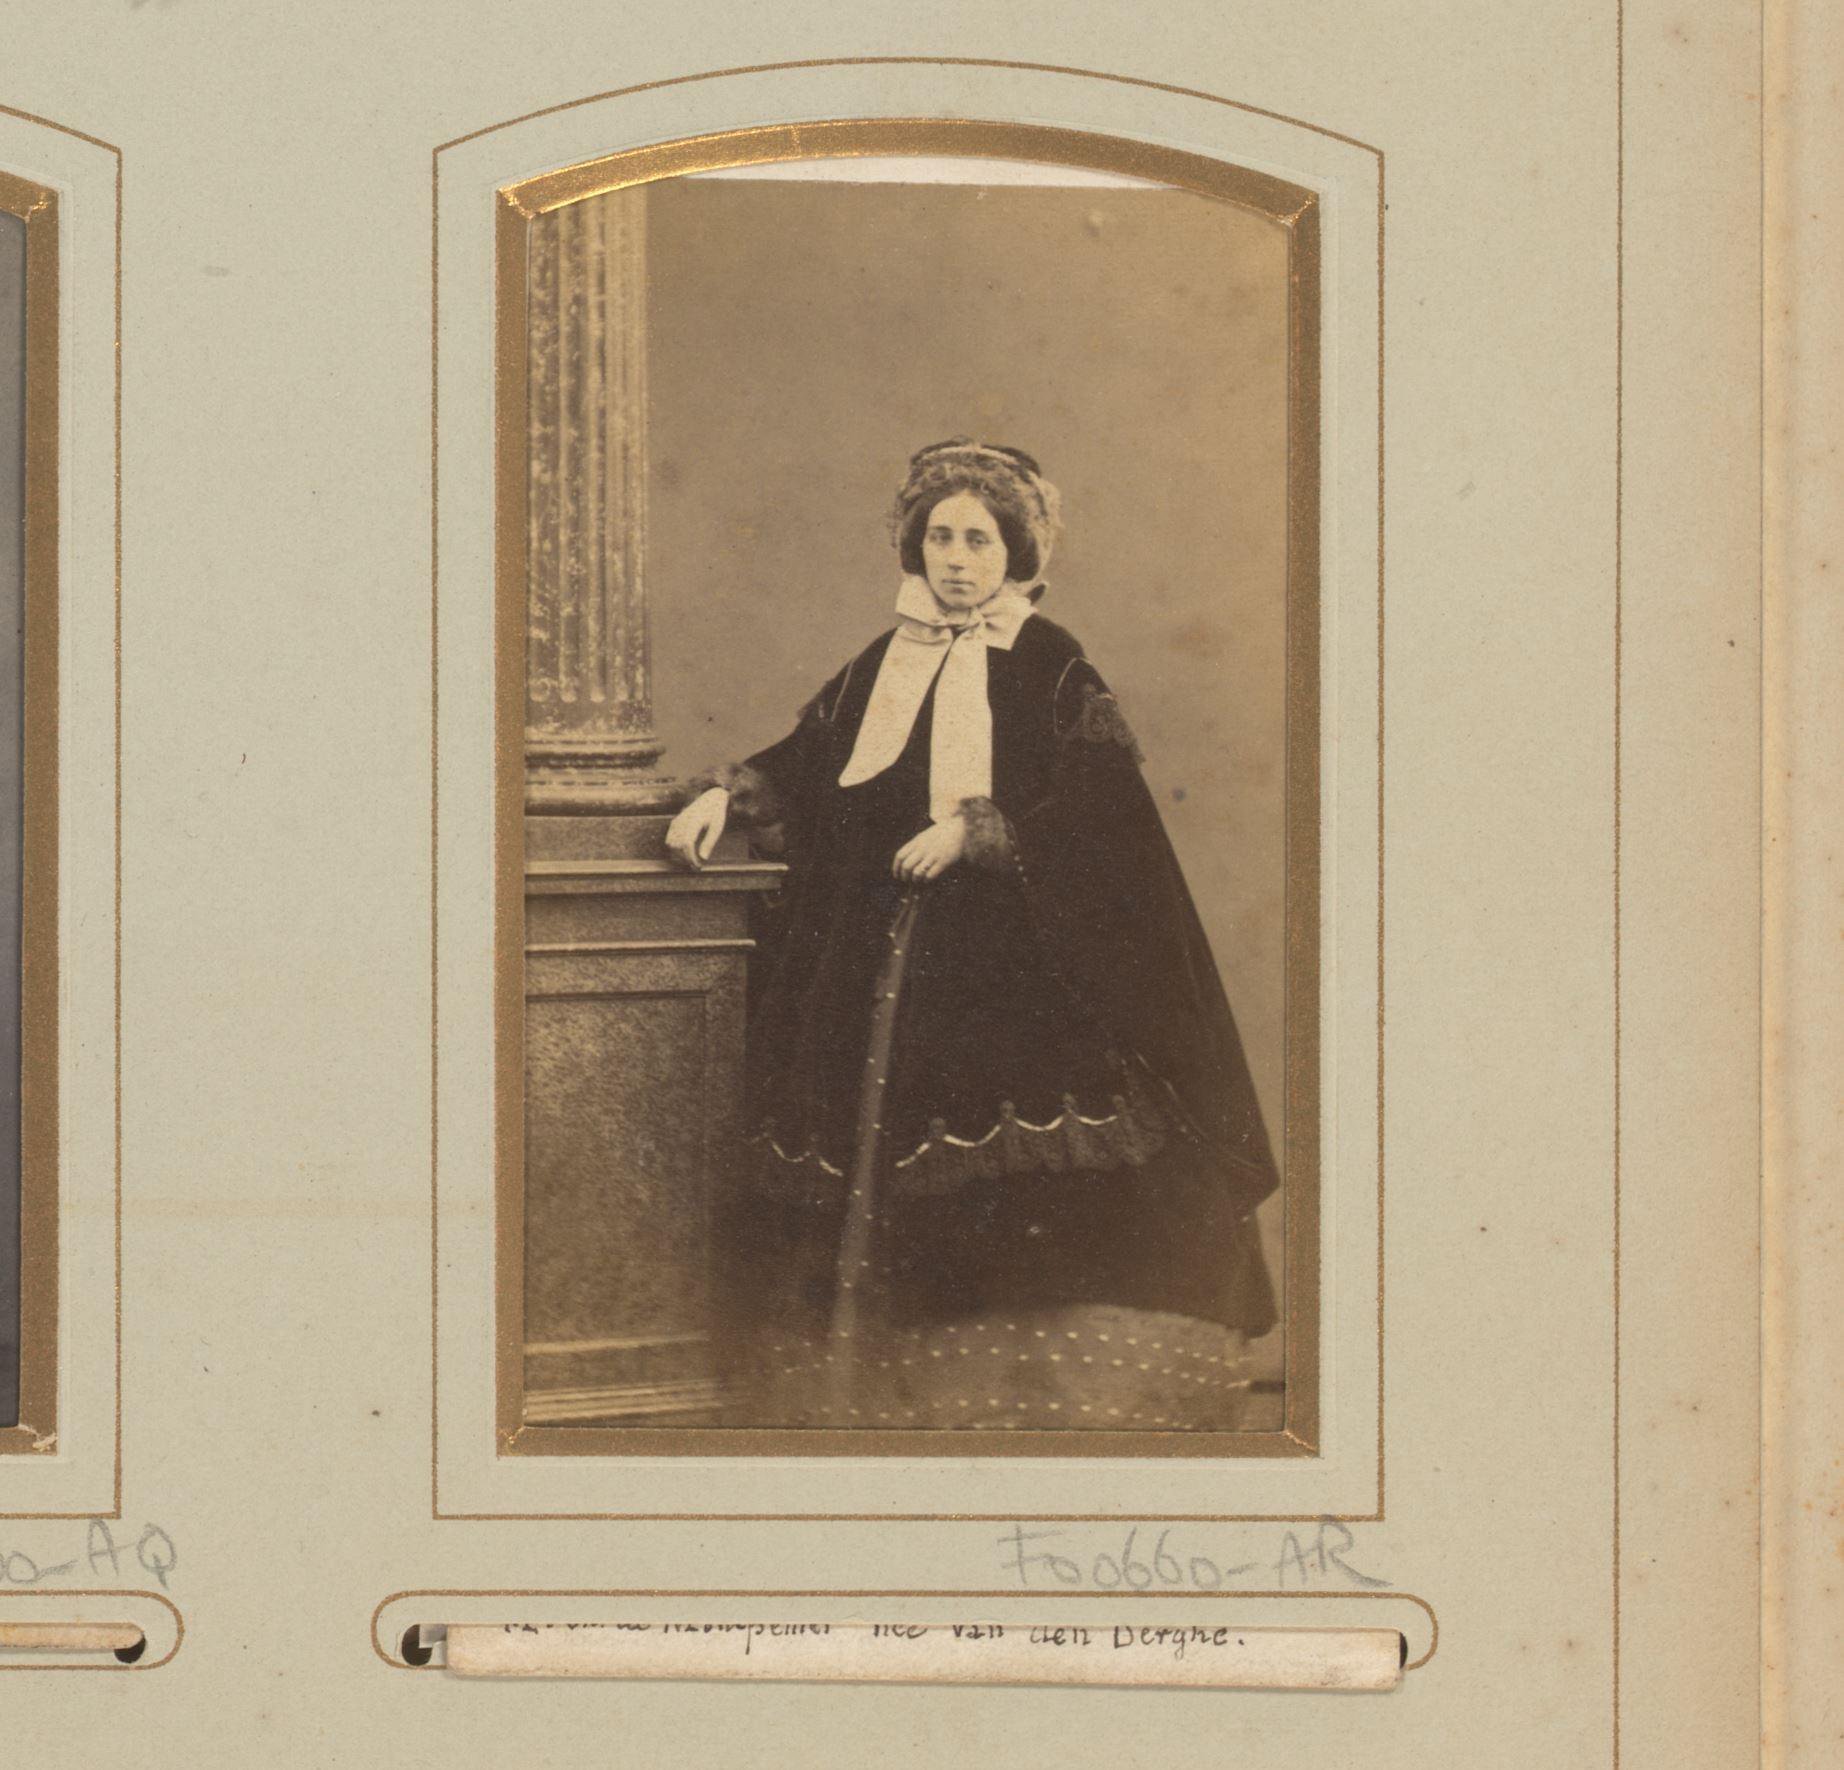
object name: photograph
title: Portret van Adeline Montpellier-van den Berghe met mantel en hoed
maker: jules géruzet (fotograaf)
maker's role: fotograaf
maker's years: 1817-1874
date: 1861-1870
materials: cardboard, photographic support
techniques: albumen print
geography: brussels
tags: historical persons - bb - woman, coat, head-gear: hat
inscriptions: inscription: ‘ATELIER DE PHOTOGRAPHIE/ DE/ J. GÉRUZET, Editeur d'Estampes./ 27bis, Rue de l'Ecuyer,/ BRUXELLES.’, name: ‘Mme Ch. de Montpellier née van den Berghe.’